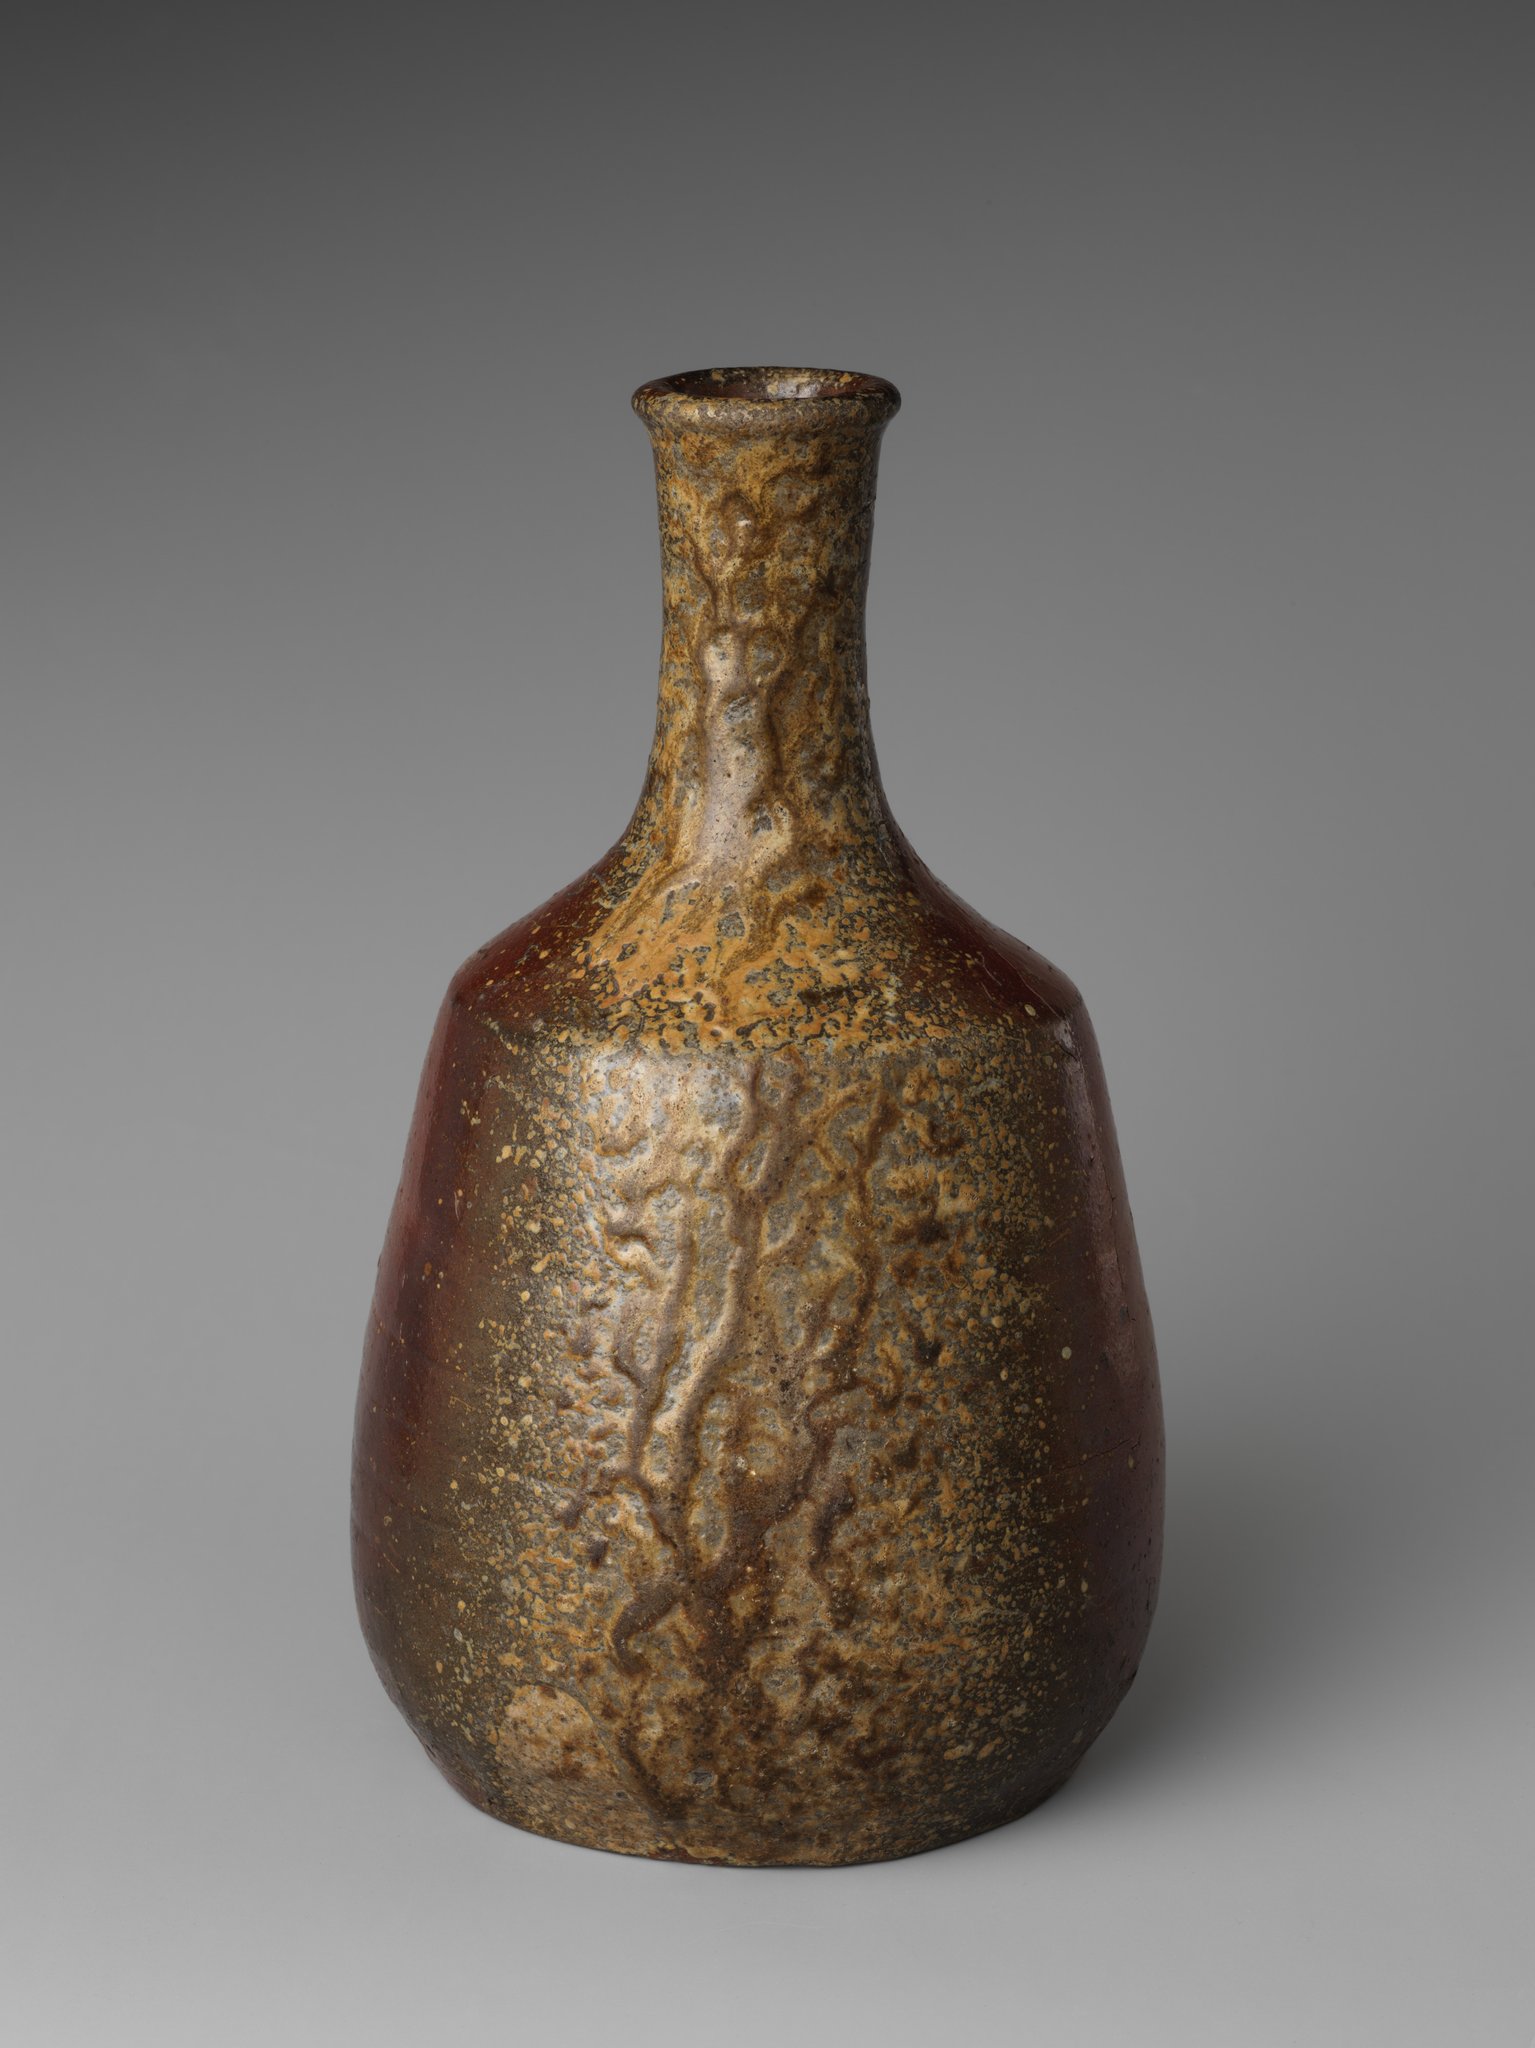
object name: sake bottle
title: Sake Bottle (Tokkuri)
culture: japanese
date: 1701-1733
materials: glaze, iron, stoneware